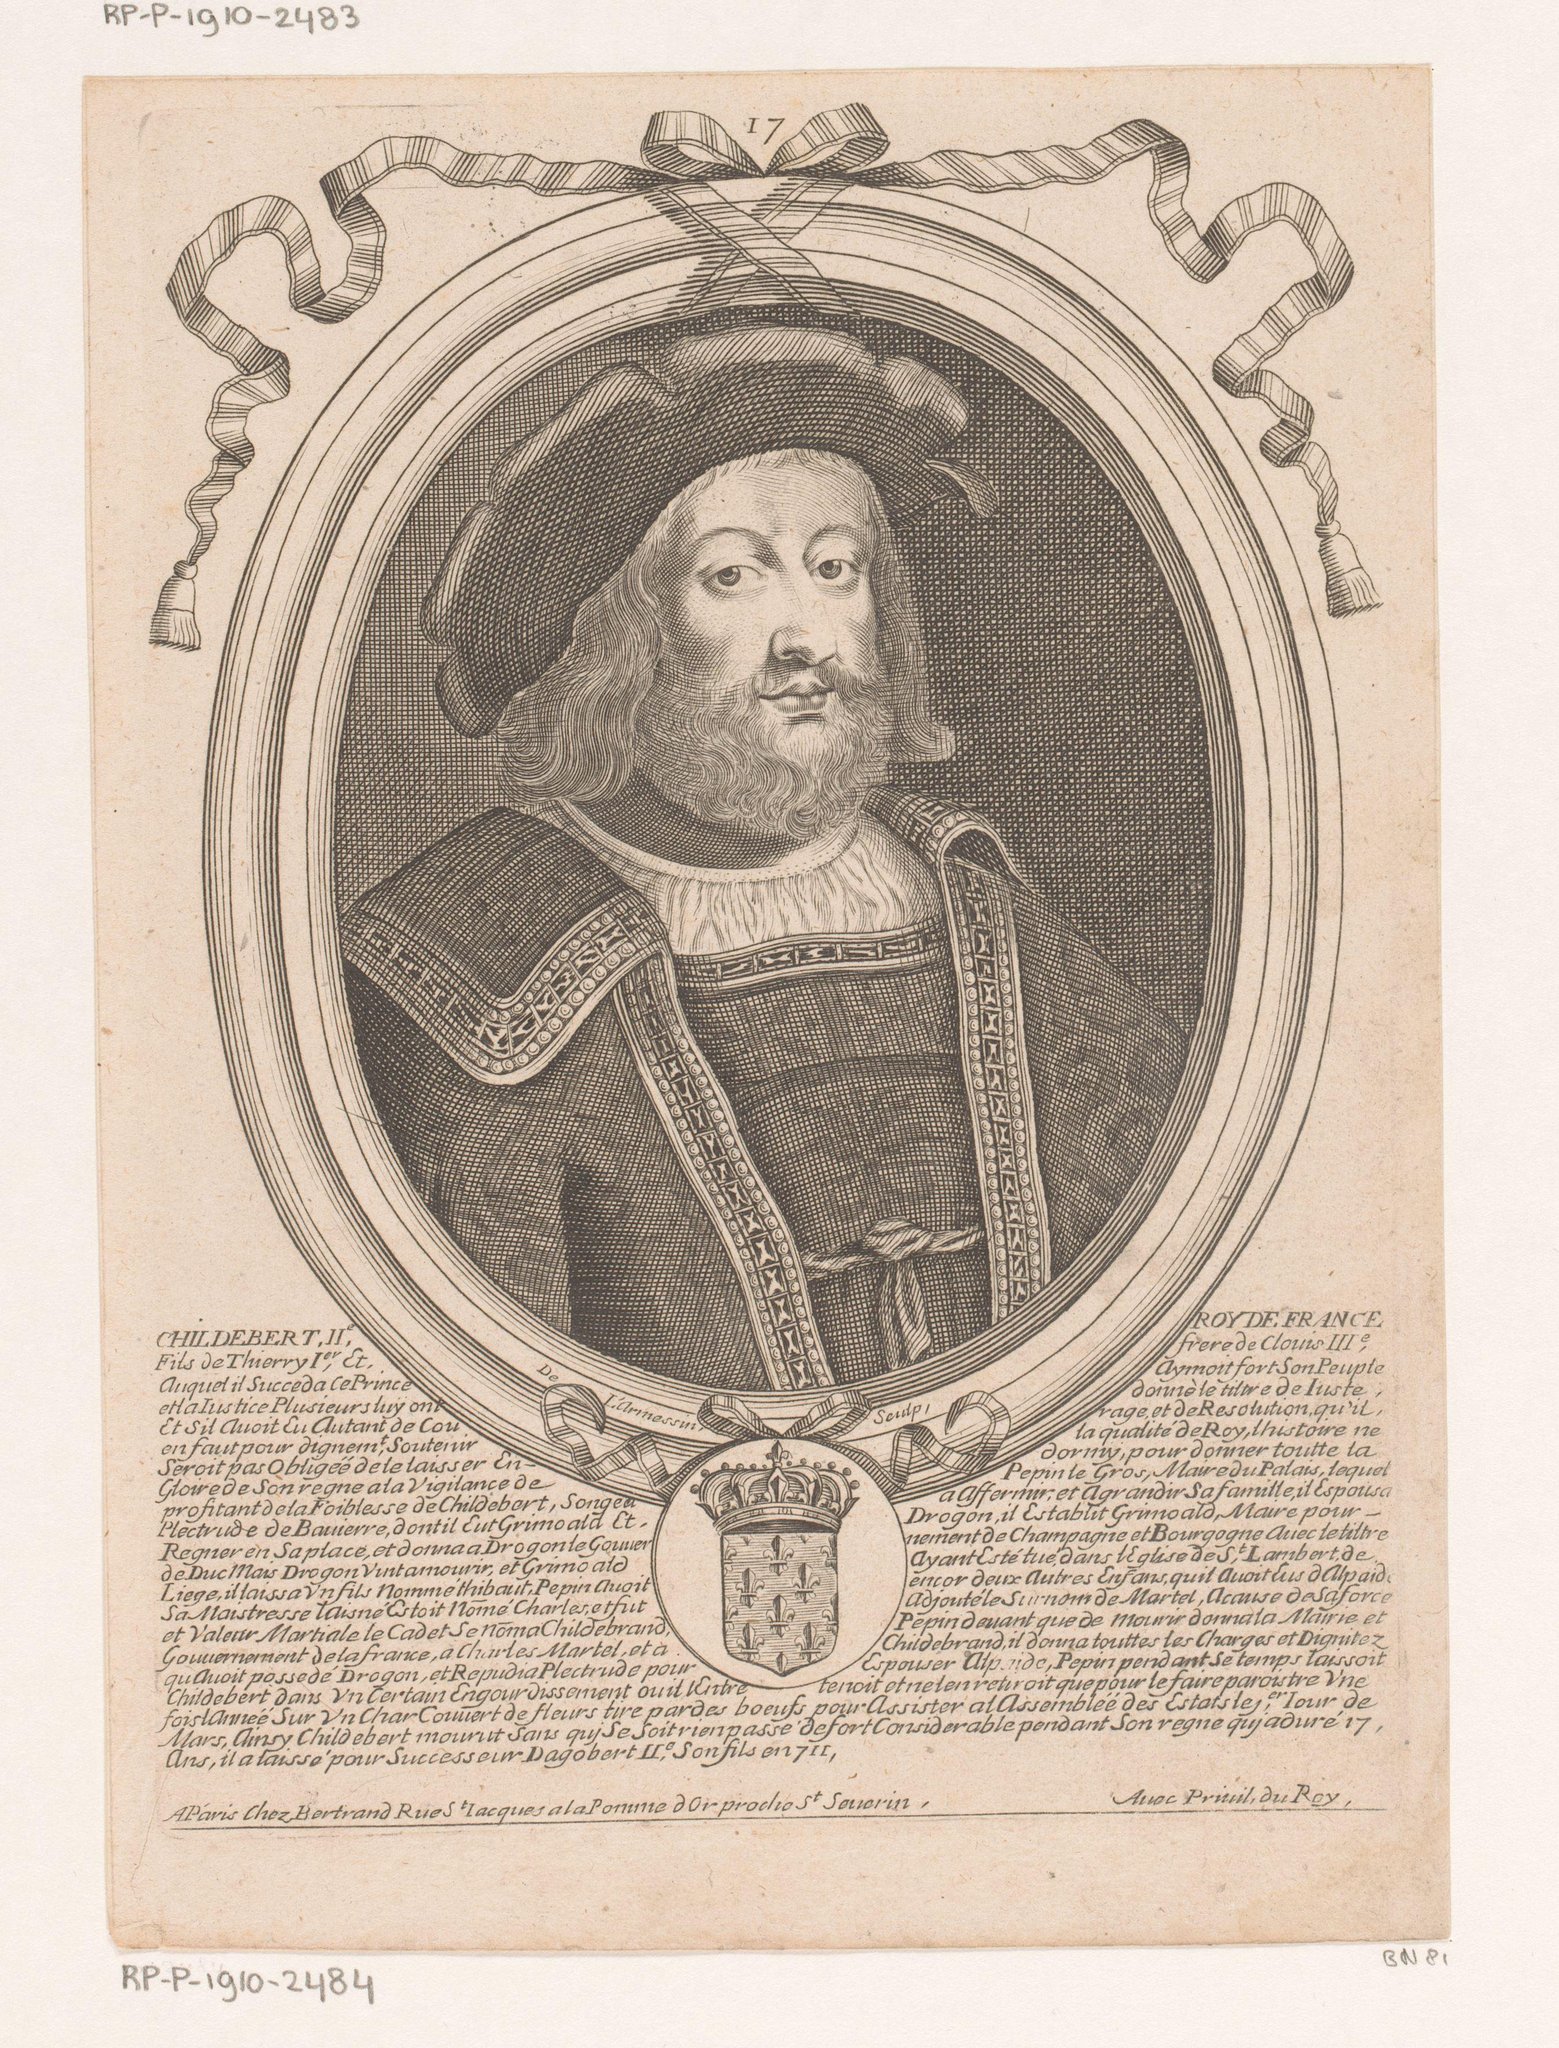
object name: print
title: Portret van Childebert II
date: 1647-1678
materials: paper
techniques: engraving, etching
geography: france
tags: historical persons, king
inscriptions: collector's mark: Lugt 2228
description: Maakt deel uit van een grootschalige serie met portretten van prominente figuren. Binnen de serie bevindt zich een sectie getiteld 'Les Augustes Représentations De tous les Roys De France depuis Pharamond Iusqu'à Louys XIIII'. De serie werd respectievelijk uitgegeven door Pierre Bertrand, door zijn weduwe en door De Larmessin zelf.